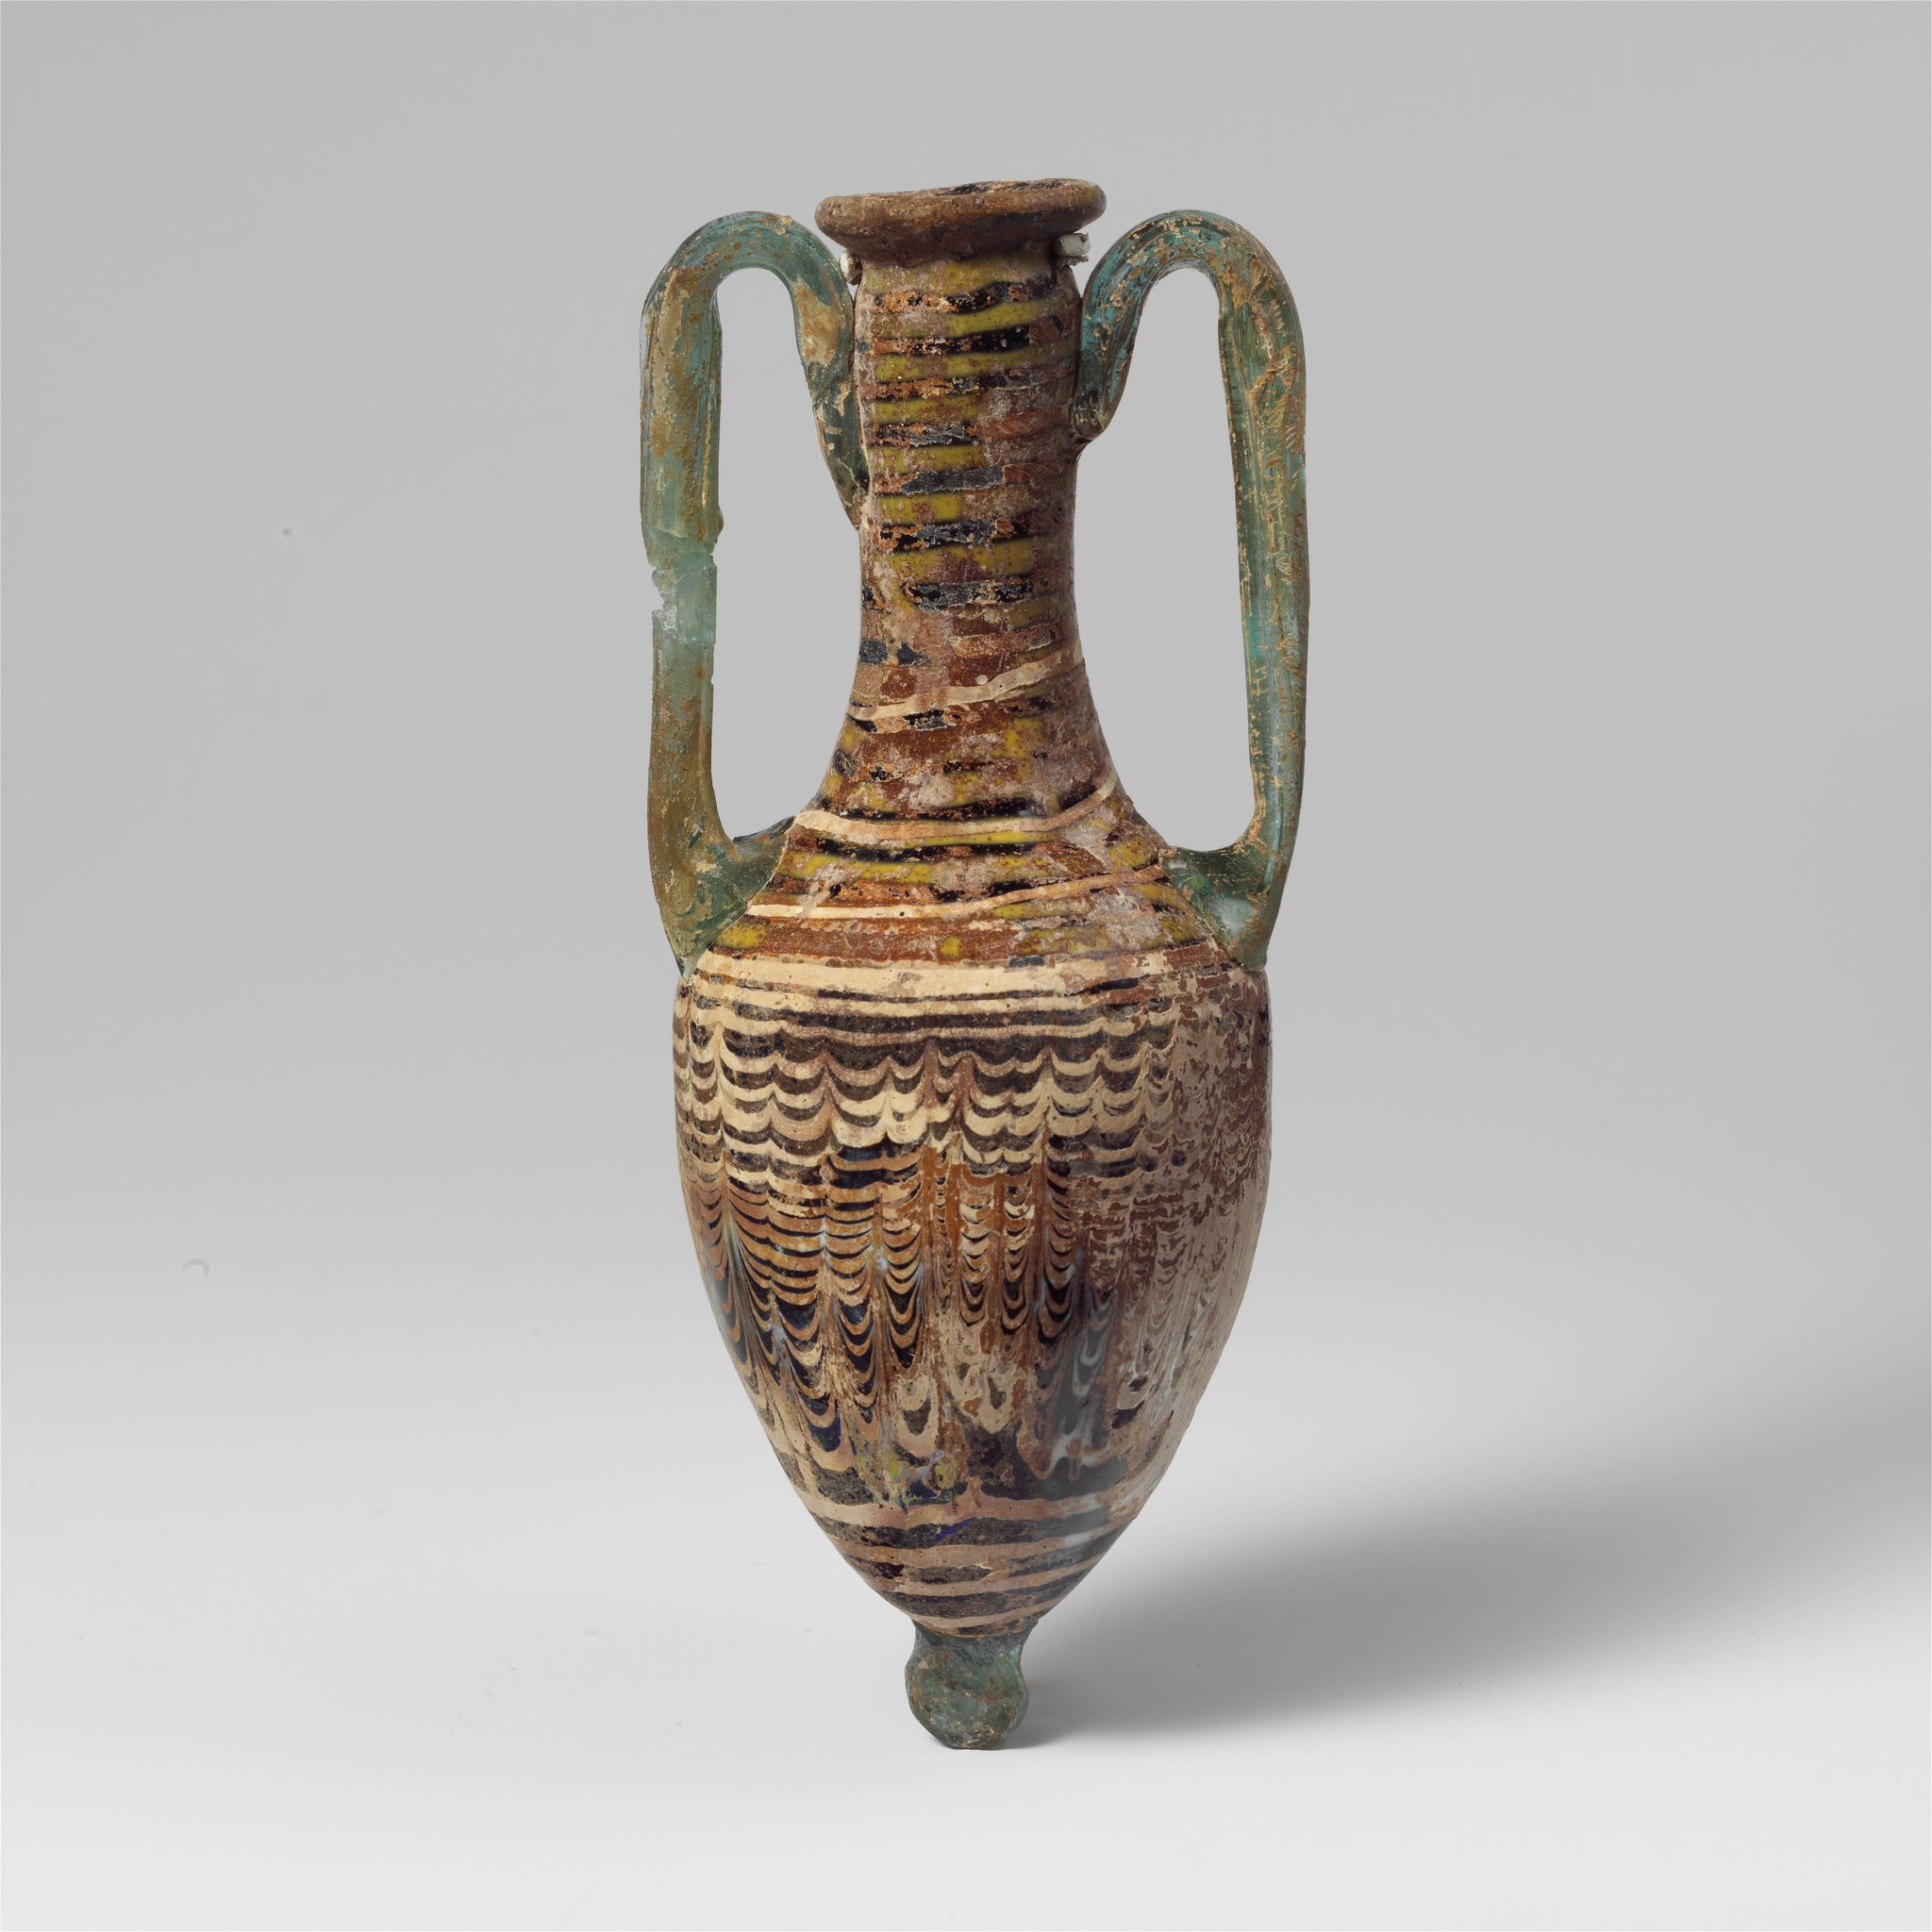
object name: amphoriskos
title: Glass amphoriskos (perfume bottle)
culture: greek, eastern mediterranean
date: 200-35 BCE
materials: glass